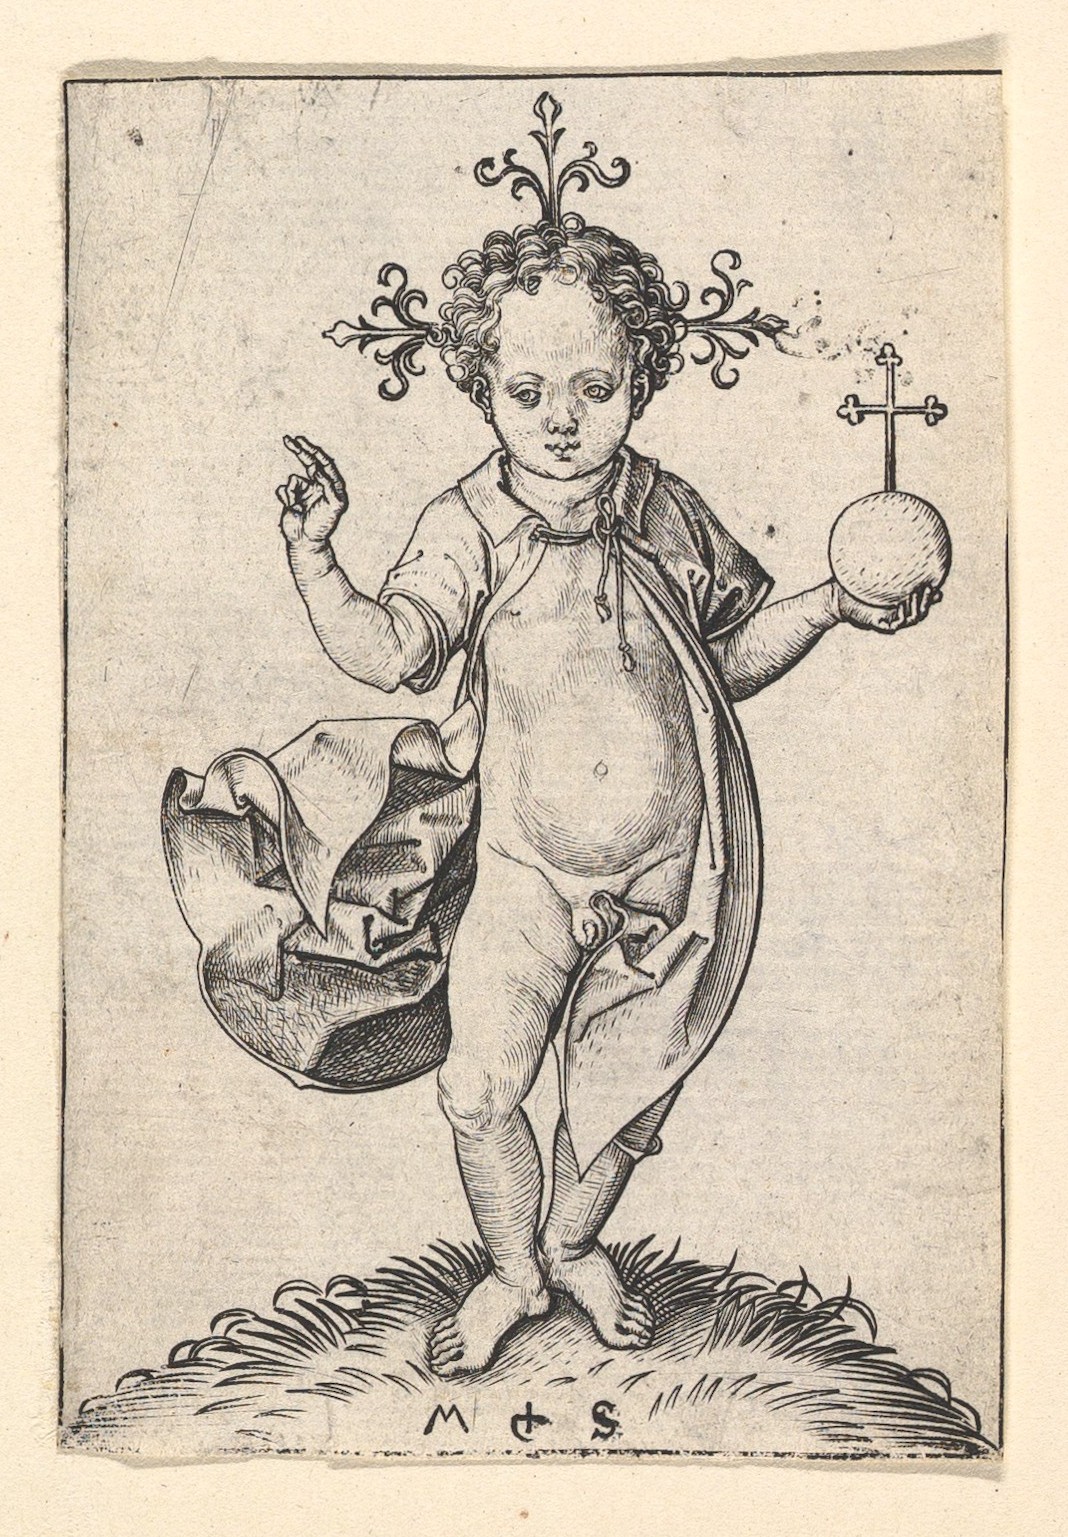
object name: print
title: The Christ Child with an Orb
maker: martin schongauer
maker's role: artist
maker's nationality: german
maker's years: 1430-1491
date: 1469-1482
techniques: engraving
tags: children,jesus